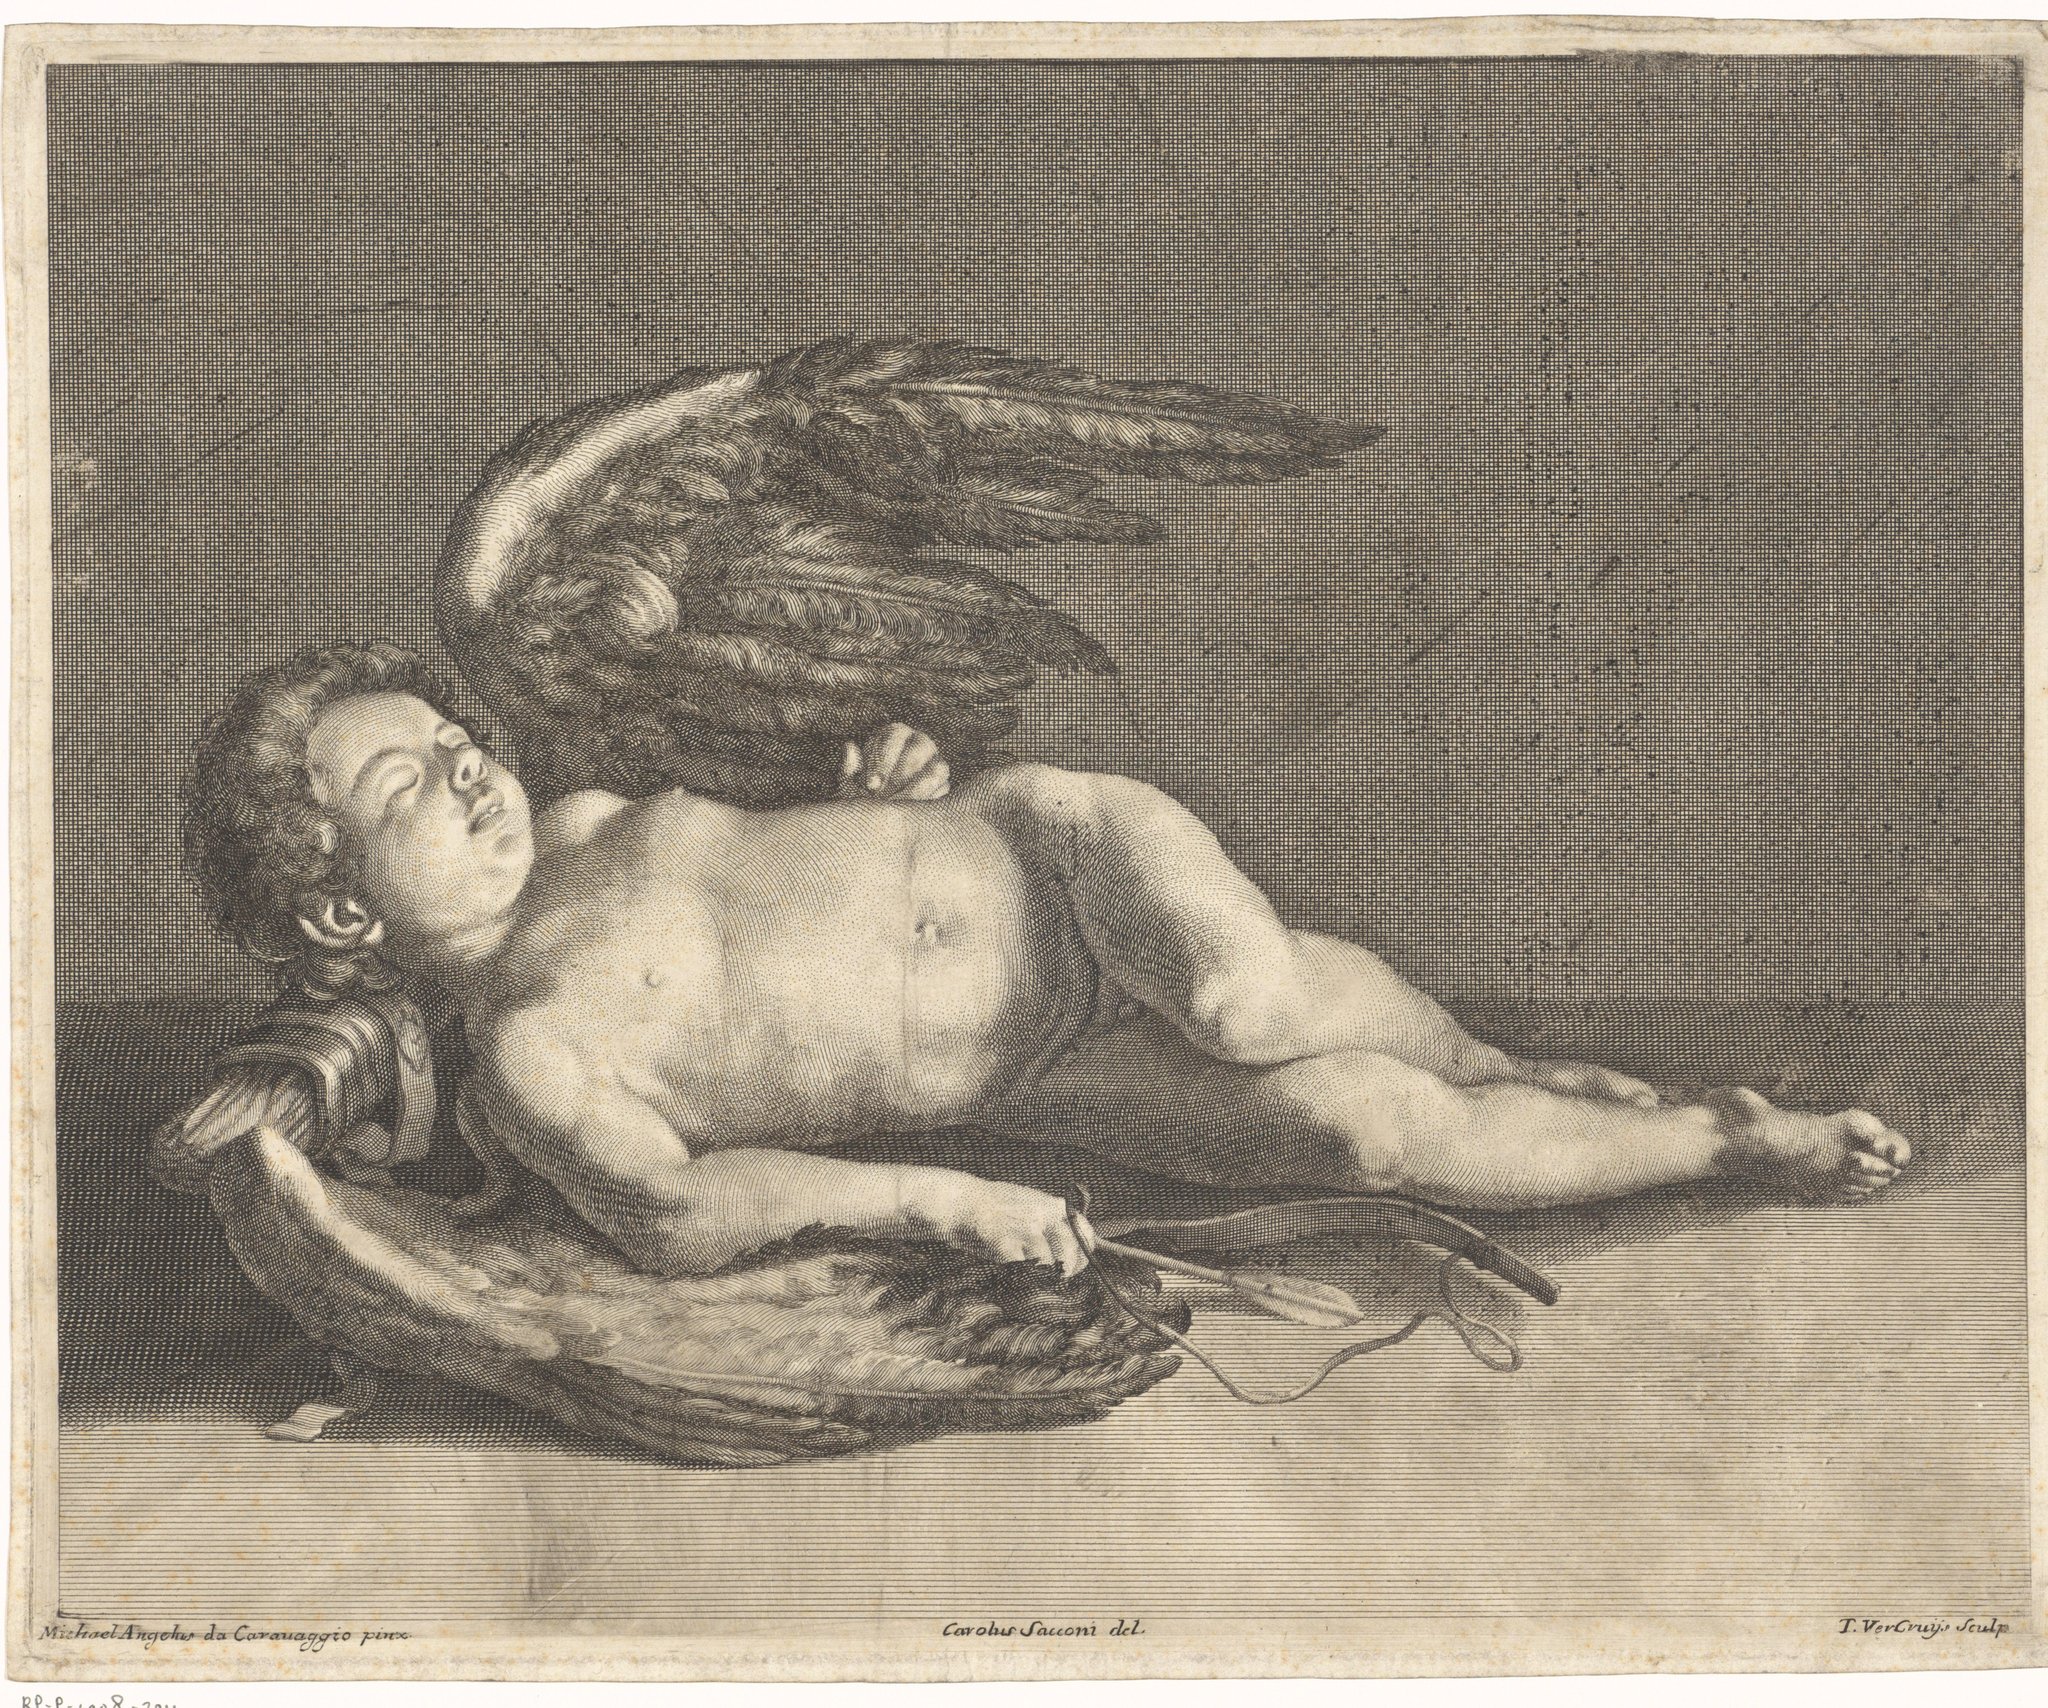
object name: print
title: Slapende Amor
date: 1690-1739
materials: paper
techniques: engraving, etching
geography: italy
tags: (story of) cupid, amor (eros), sleeping on the ground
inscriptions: collector's mark: Lugt 2228